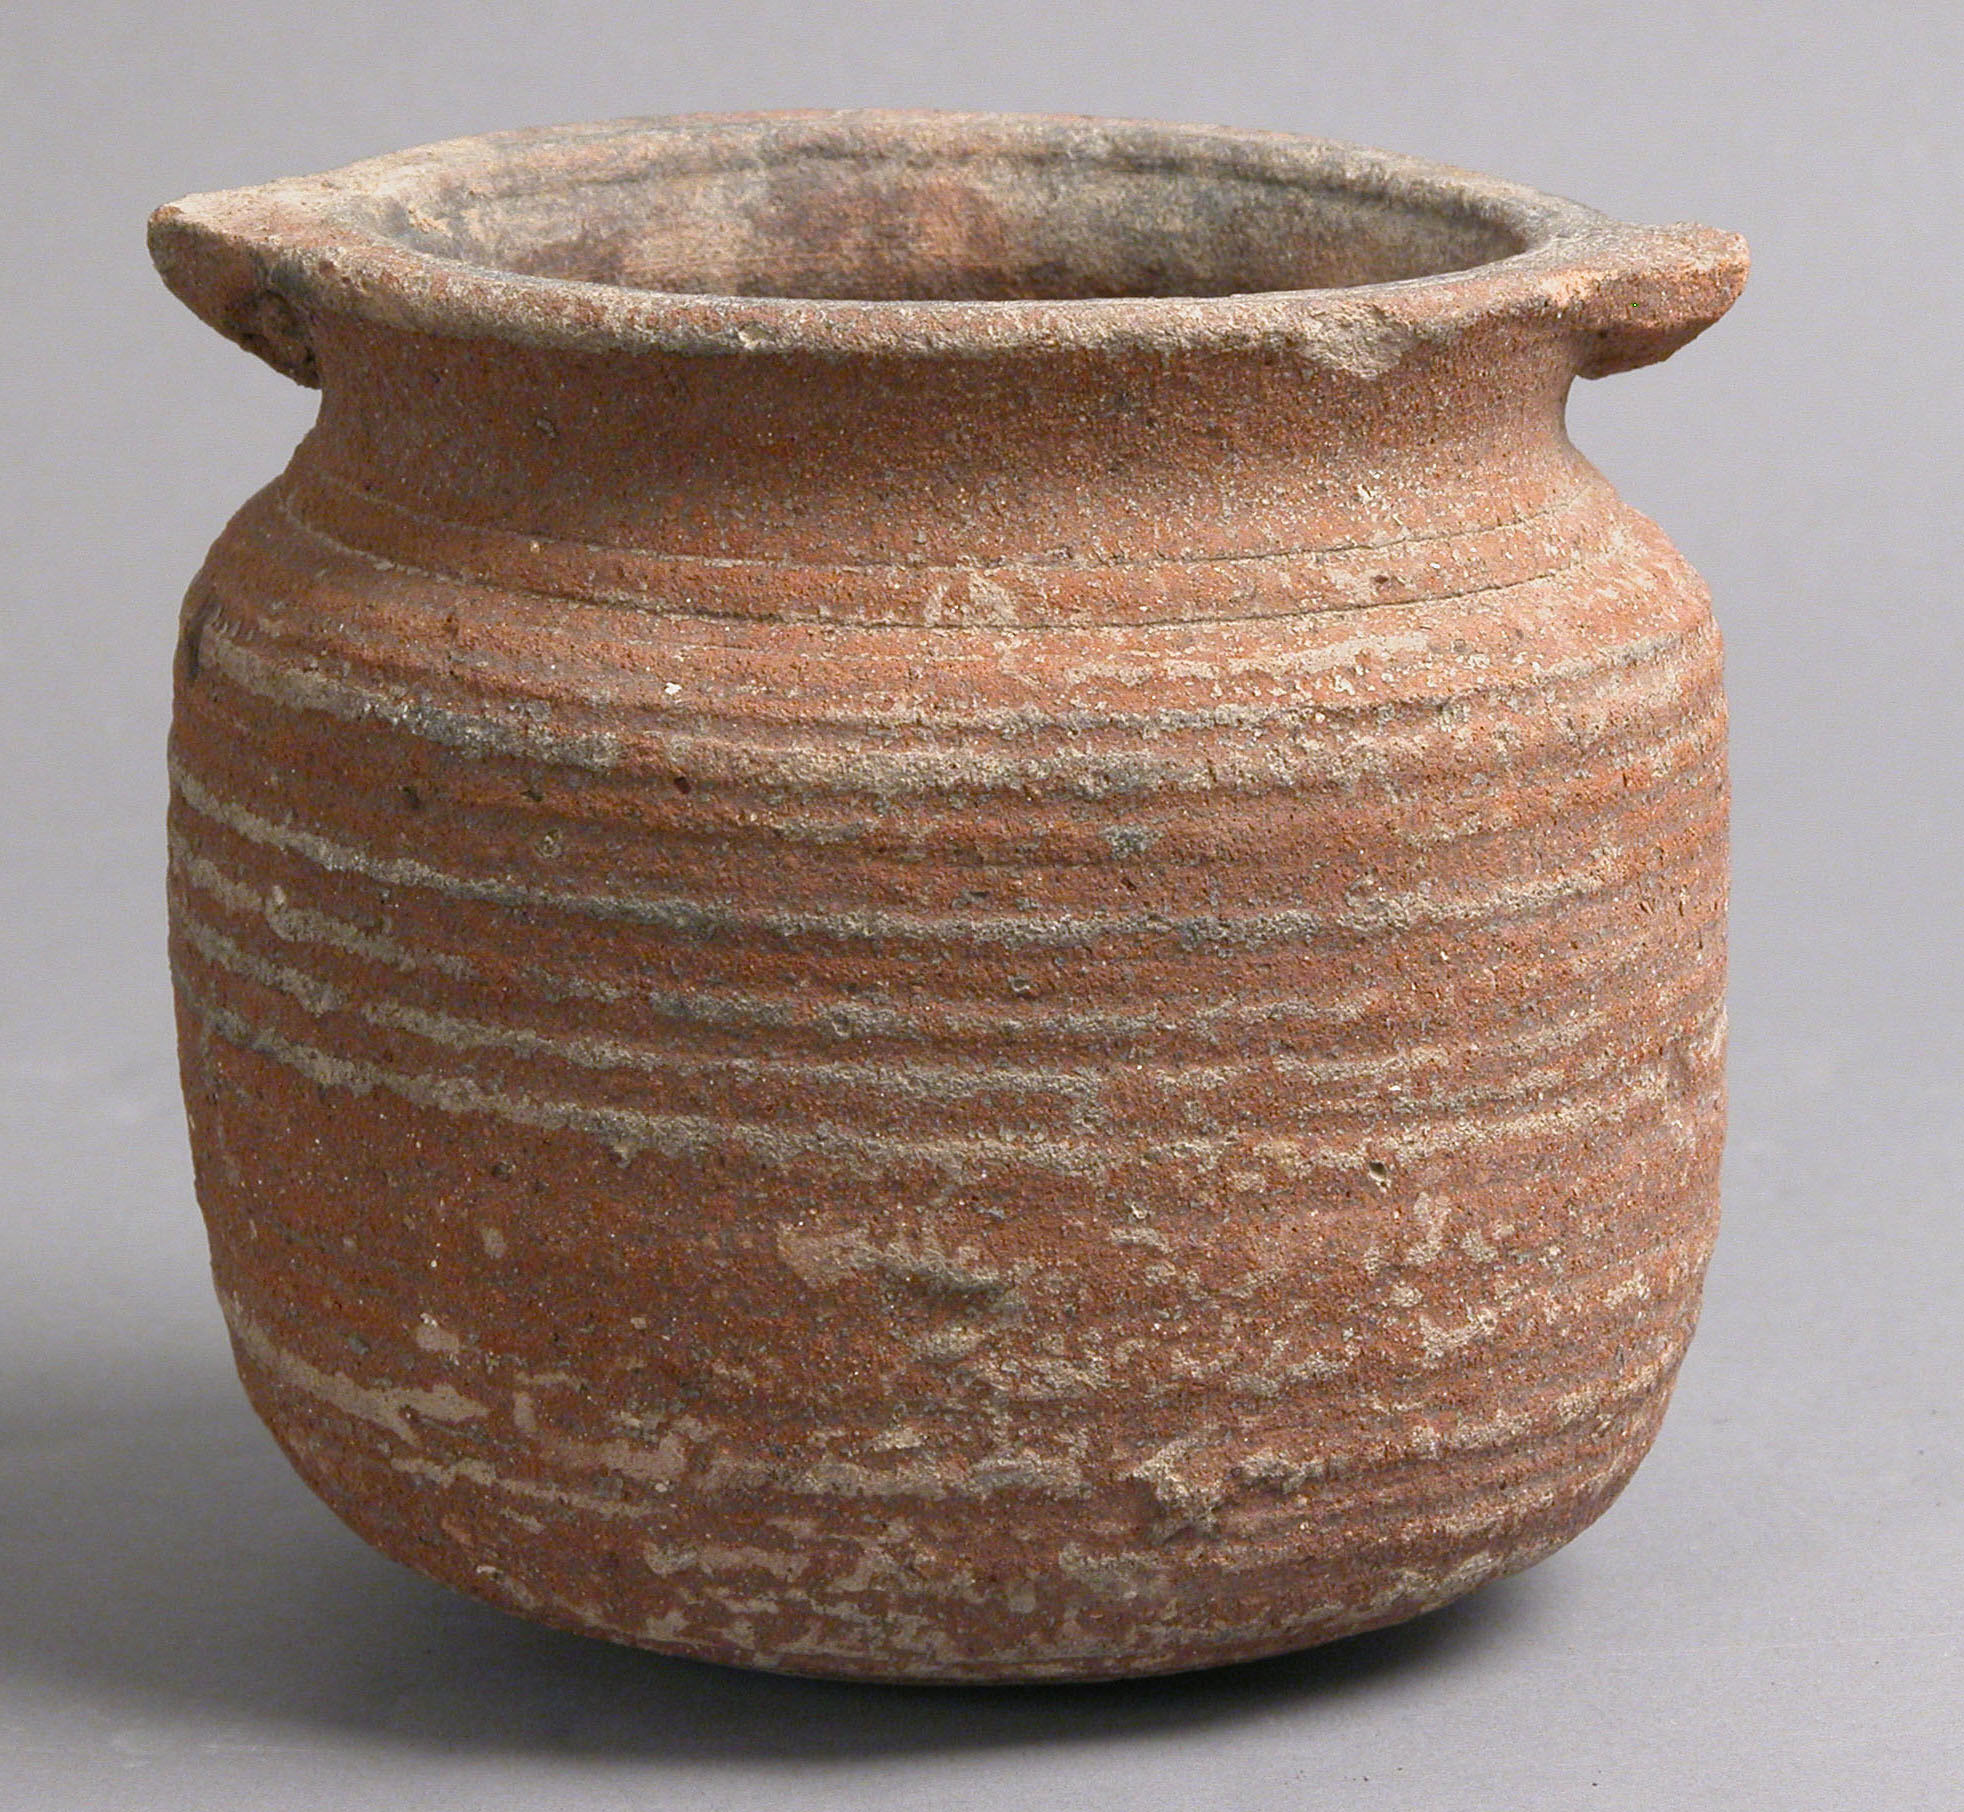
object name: pot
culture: coptic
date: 301-700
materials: earthenware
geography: egypt